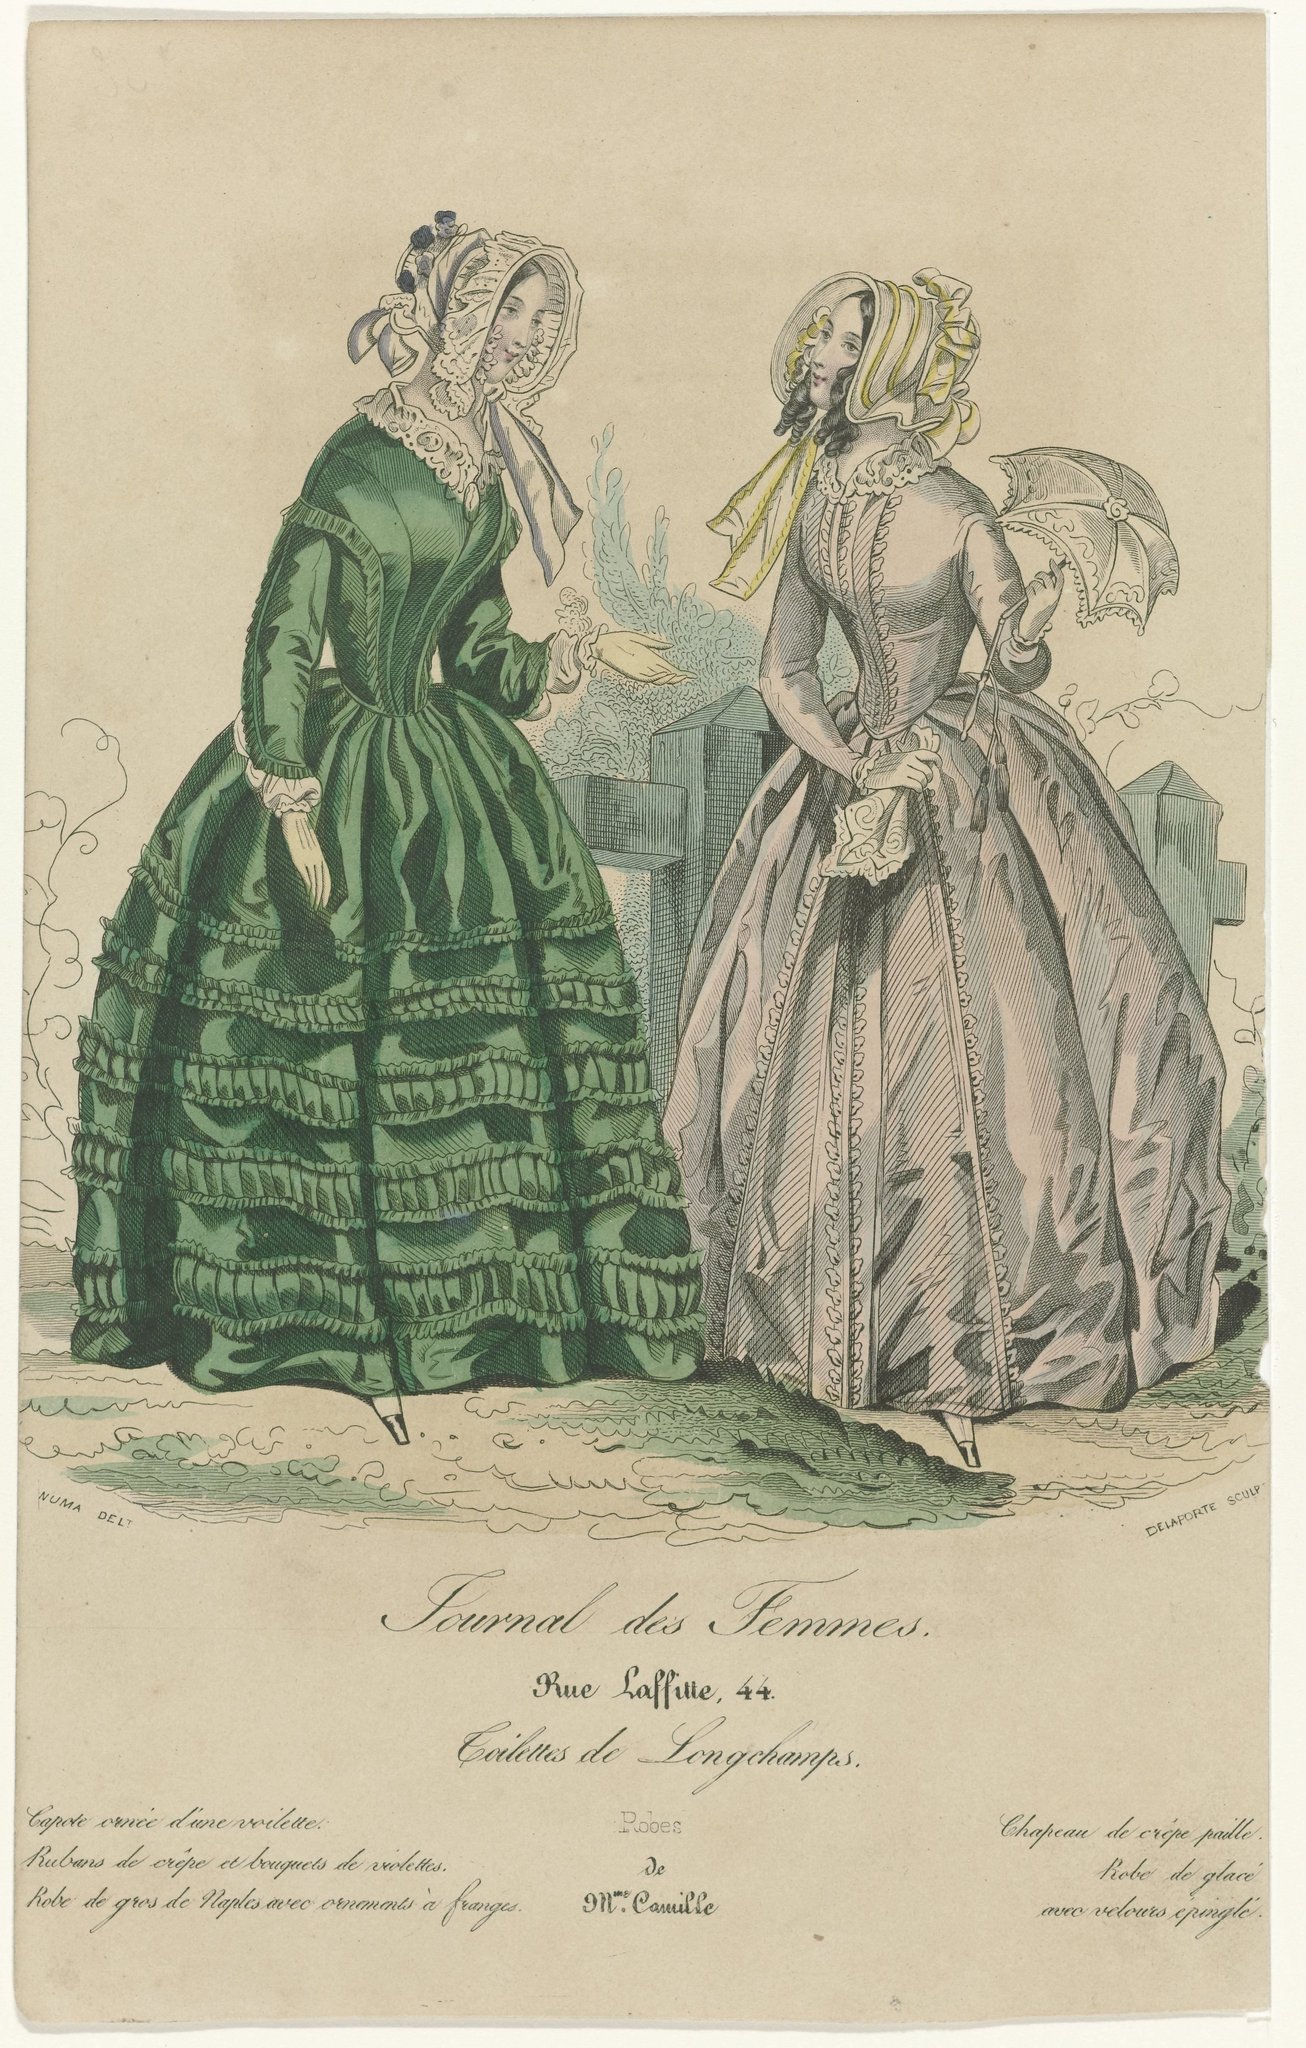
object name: fashion print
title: Journal des Femmes, ca. 1840 : Toilettes de Longchamps (...)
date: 1840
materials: paper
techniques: engraving, hand coloring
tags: handkerchief (+ women's clothes), flowers: violet, head-gear (capote) (+ women's clothes), ornamental parts of clothing (+ women's clothes), veil (+ women's clothes), border, ribbon, braid (+ women's clothes), fashion plates, head-gear: hat (+ women's clothes), dress, gown (+ women's clothes), parasol, sunshade (+ women's clothes)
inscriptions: address: ‘Rue Laffitte, 44.’, title: ‘Journal des Femmes’, caption: ‘Capote ornée d'une voilette. Rubans de crêpe et bouquets de violettes. Robe de gros de Naples avec ornements à franges. / Chapeau de crépe paille. Robe de glacé avec velours épinglé.’, caption: ‘Toilettes de Longchamps. / Robes de Mme. Camille.’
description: Twee vrouwen bij een hek. Volgens het onderschrift: 'toilettes de Longchamps'. Japonnen van Camille. Links: capote versierd met een 'violette'. Linten van crêpe en viooltjes. Japon van 'gros de Naples met omzoomde versieringen. Rechts: hoed van 'crêpe paille'. Japon van 'glacé' met 'velours épinglé'. Prent uit het modetijdschrift Journal des Femmes (1840-1851).